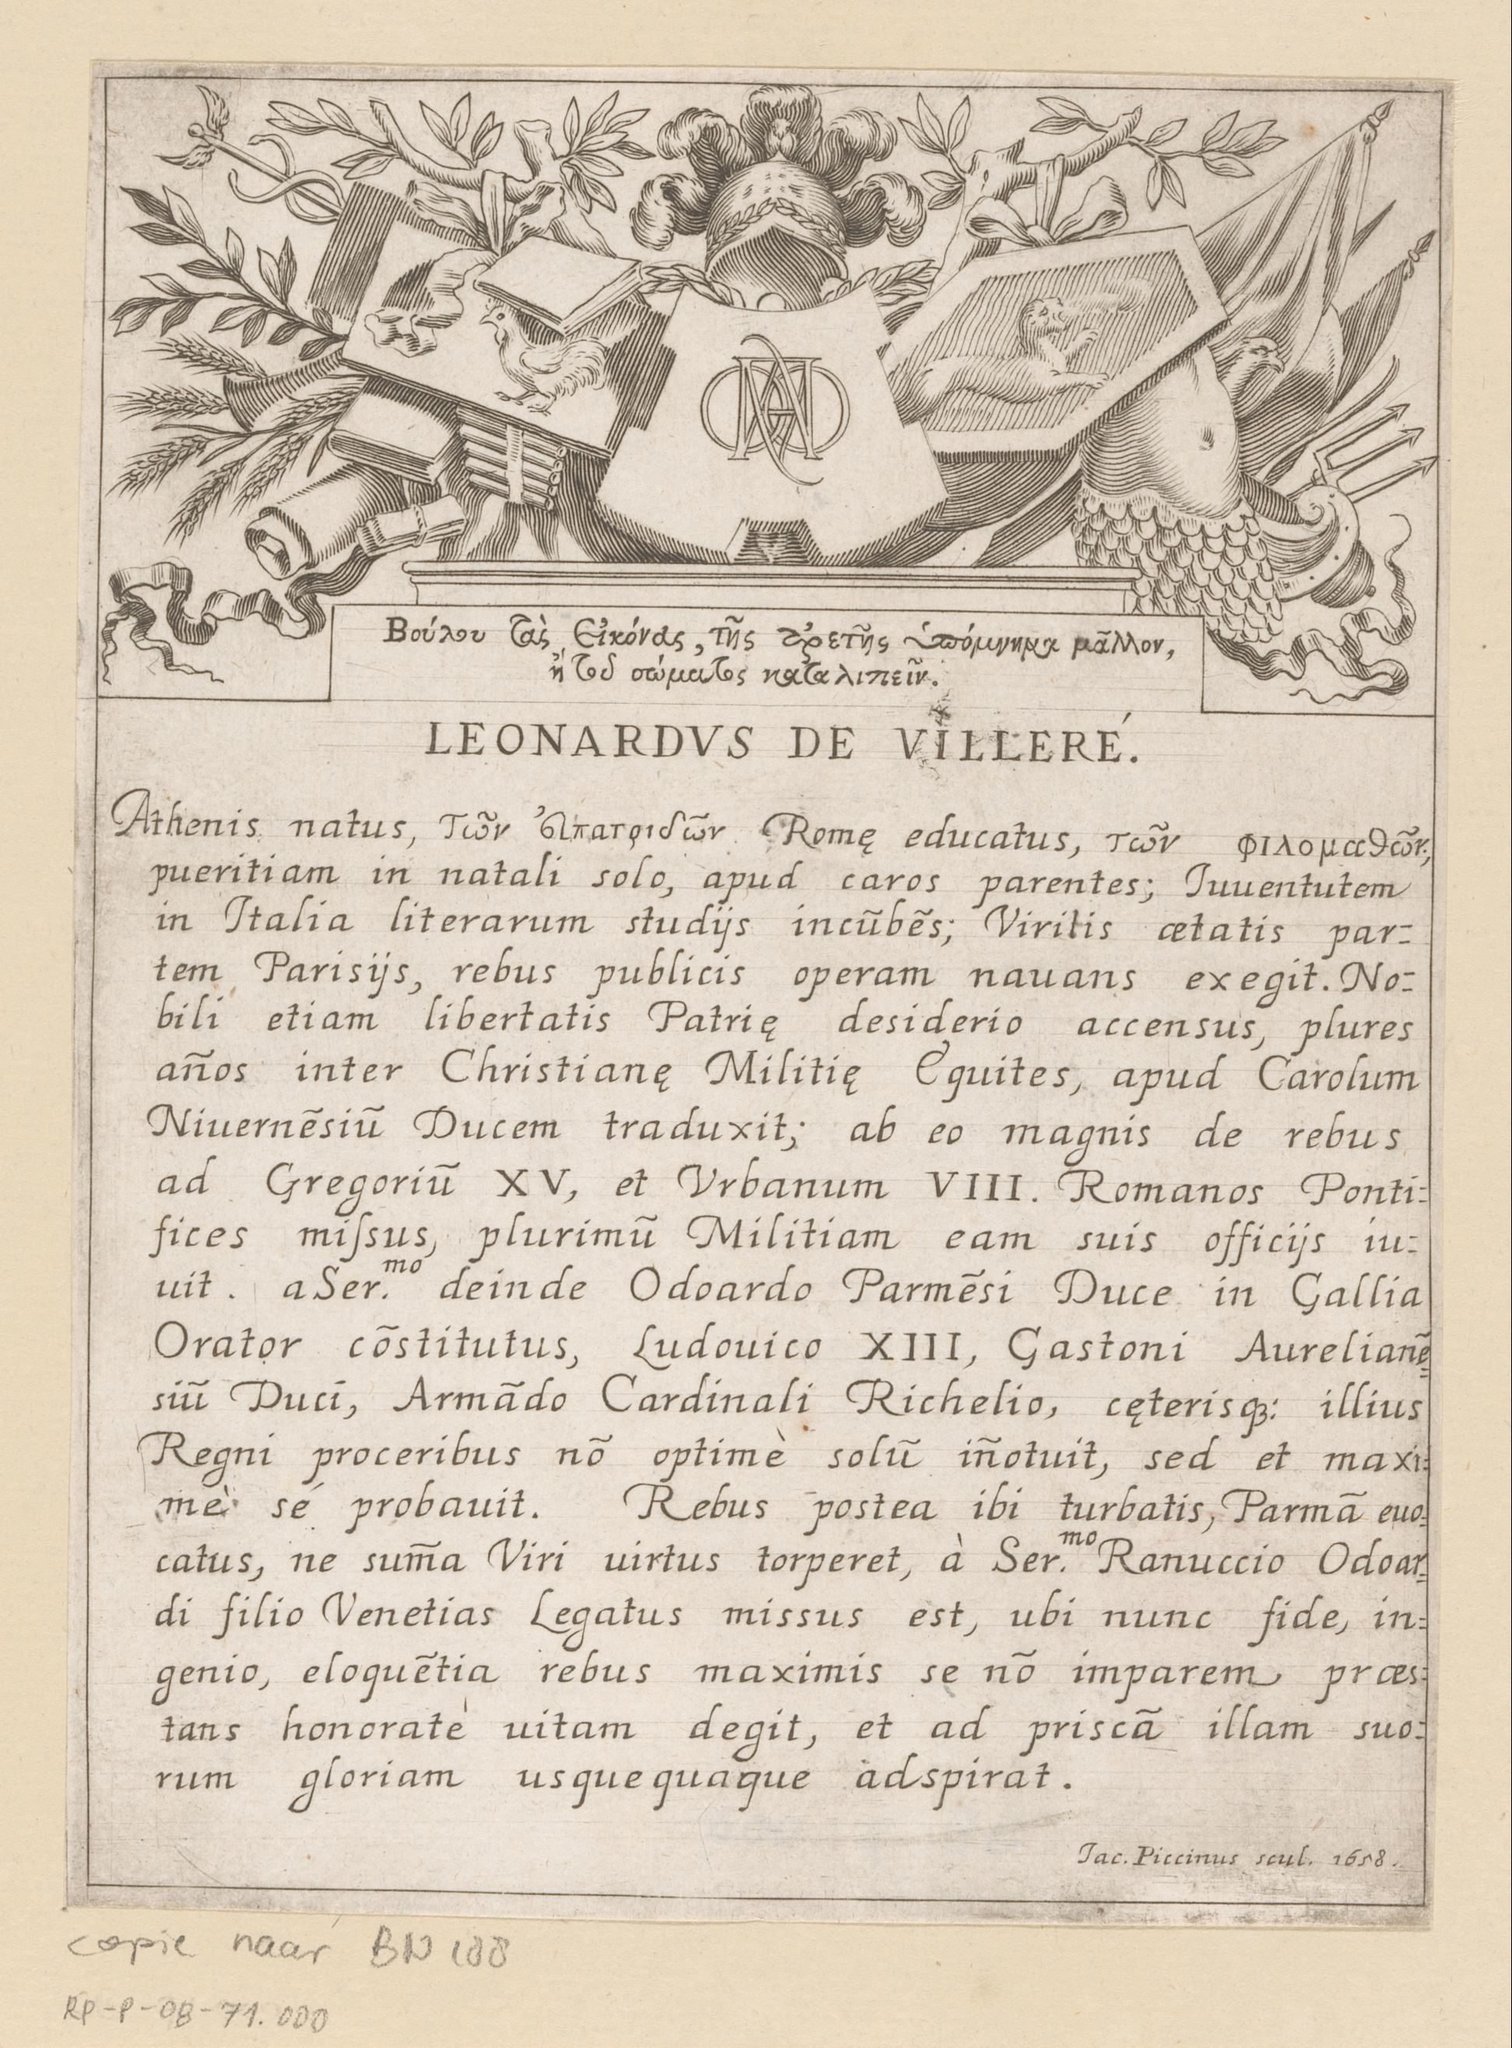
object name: print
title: Trofee en tekst bij het portret van Leonardos Philaras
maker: jacques piccinus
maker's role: print maker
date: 1658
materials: paper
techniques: engraving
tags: trophy, i.e.: decorative arrangement of symbolic or typical objects ~ ornament, historical persons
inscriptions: collector's mark: Lugt 240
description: Deze prent is een kopie naar de prent met trofee die bij het portret van Leonardos Philaras hoort.